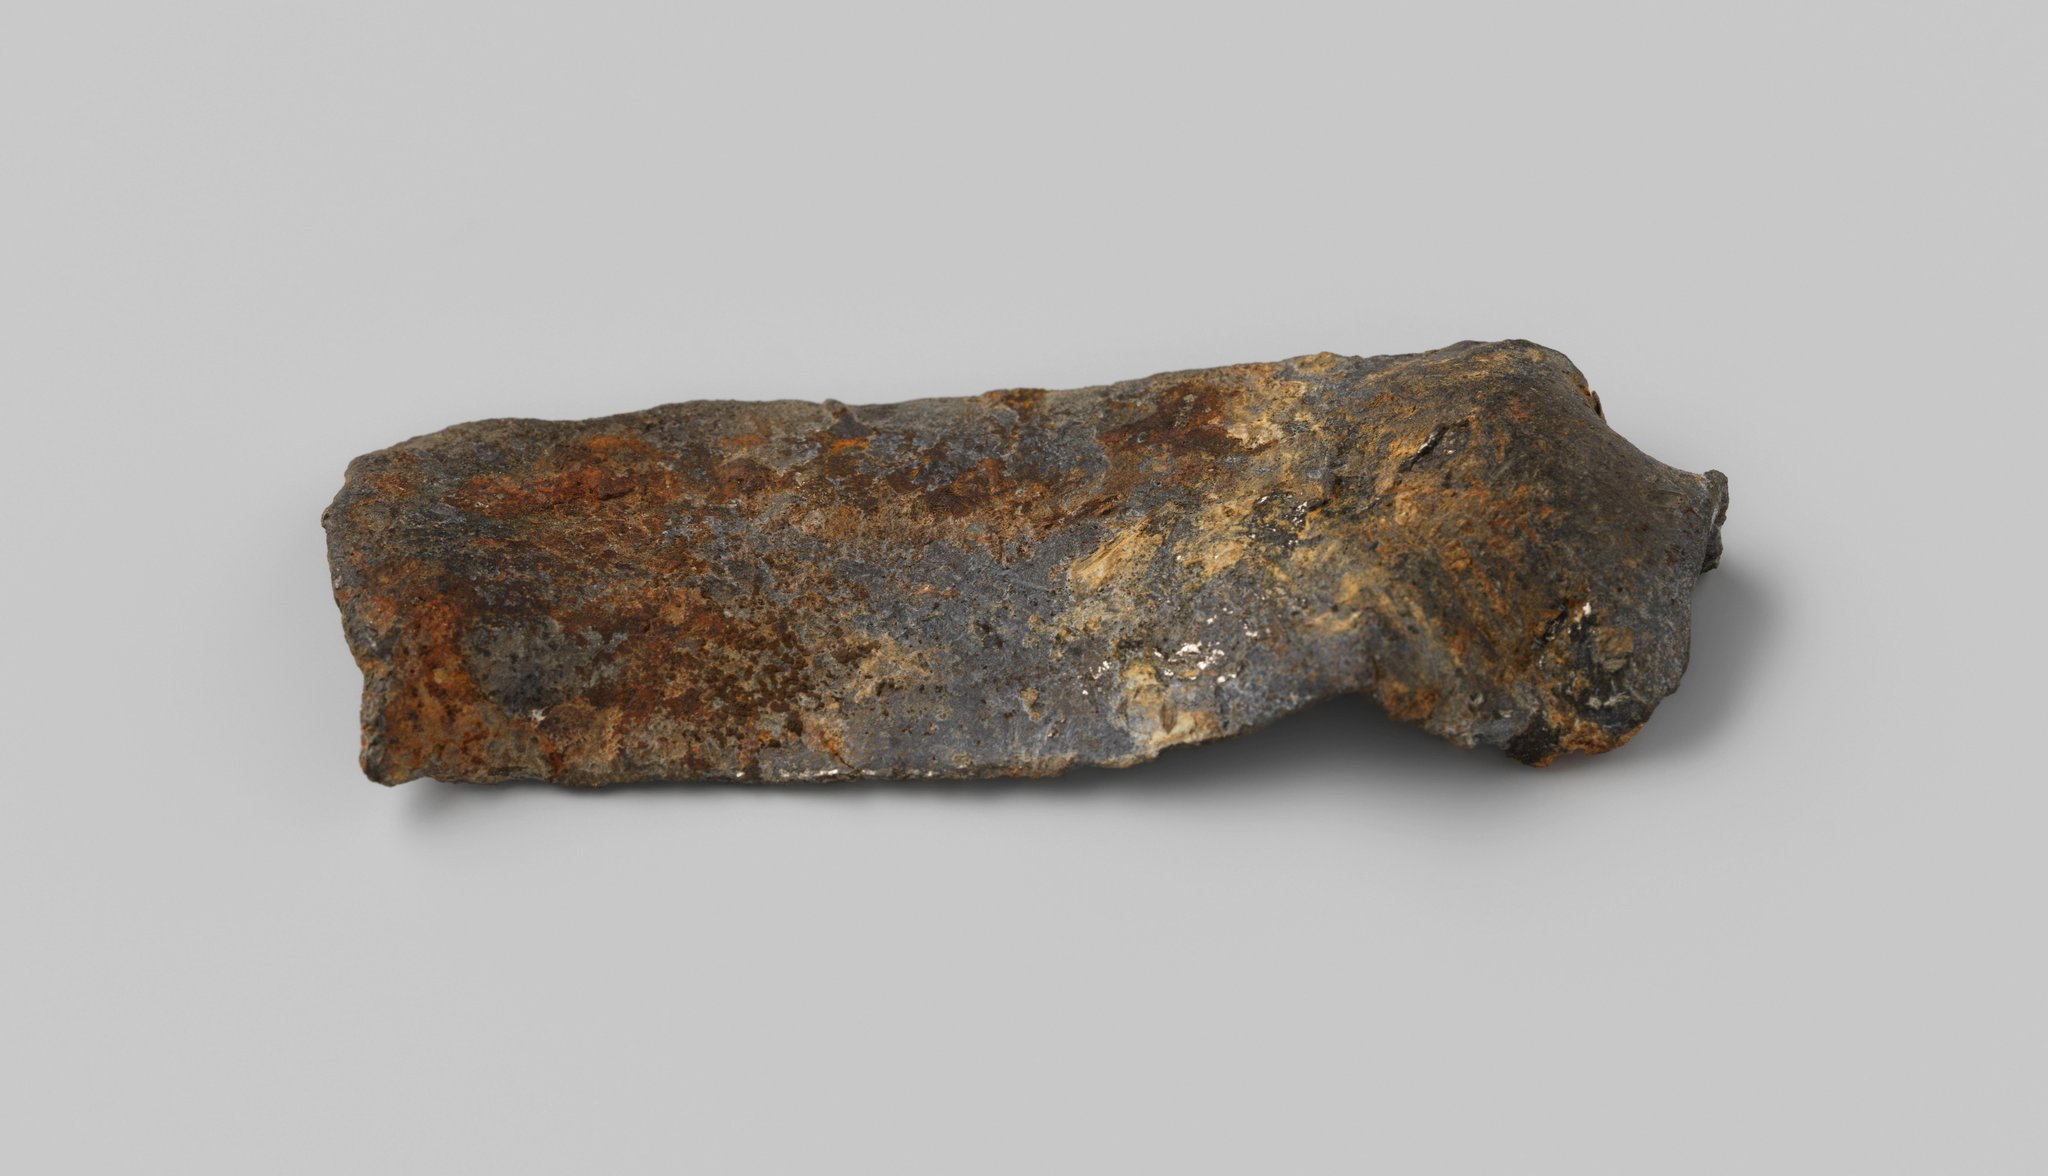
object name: fragment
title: Fragment van metaal uit het wrak van de Oost-Indiëvaarder Hollandia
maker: Anonymous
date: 1700-1743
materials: tin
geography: netherlands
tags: verenigde oostindische compagnie, hollandia (schip), annet